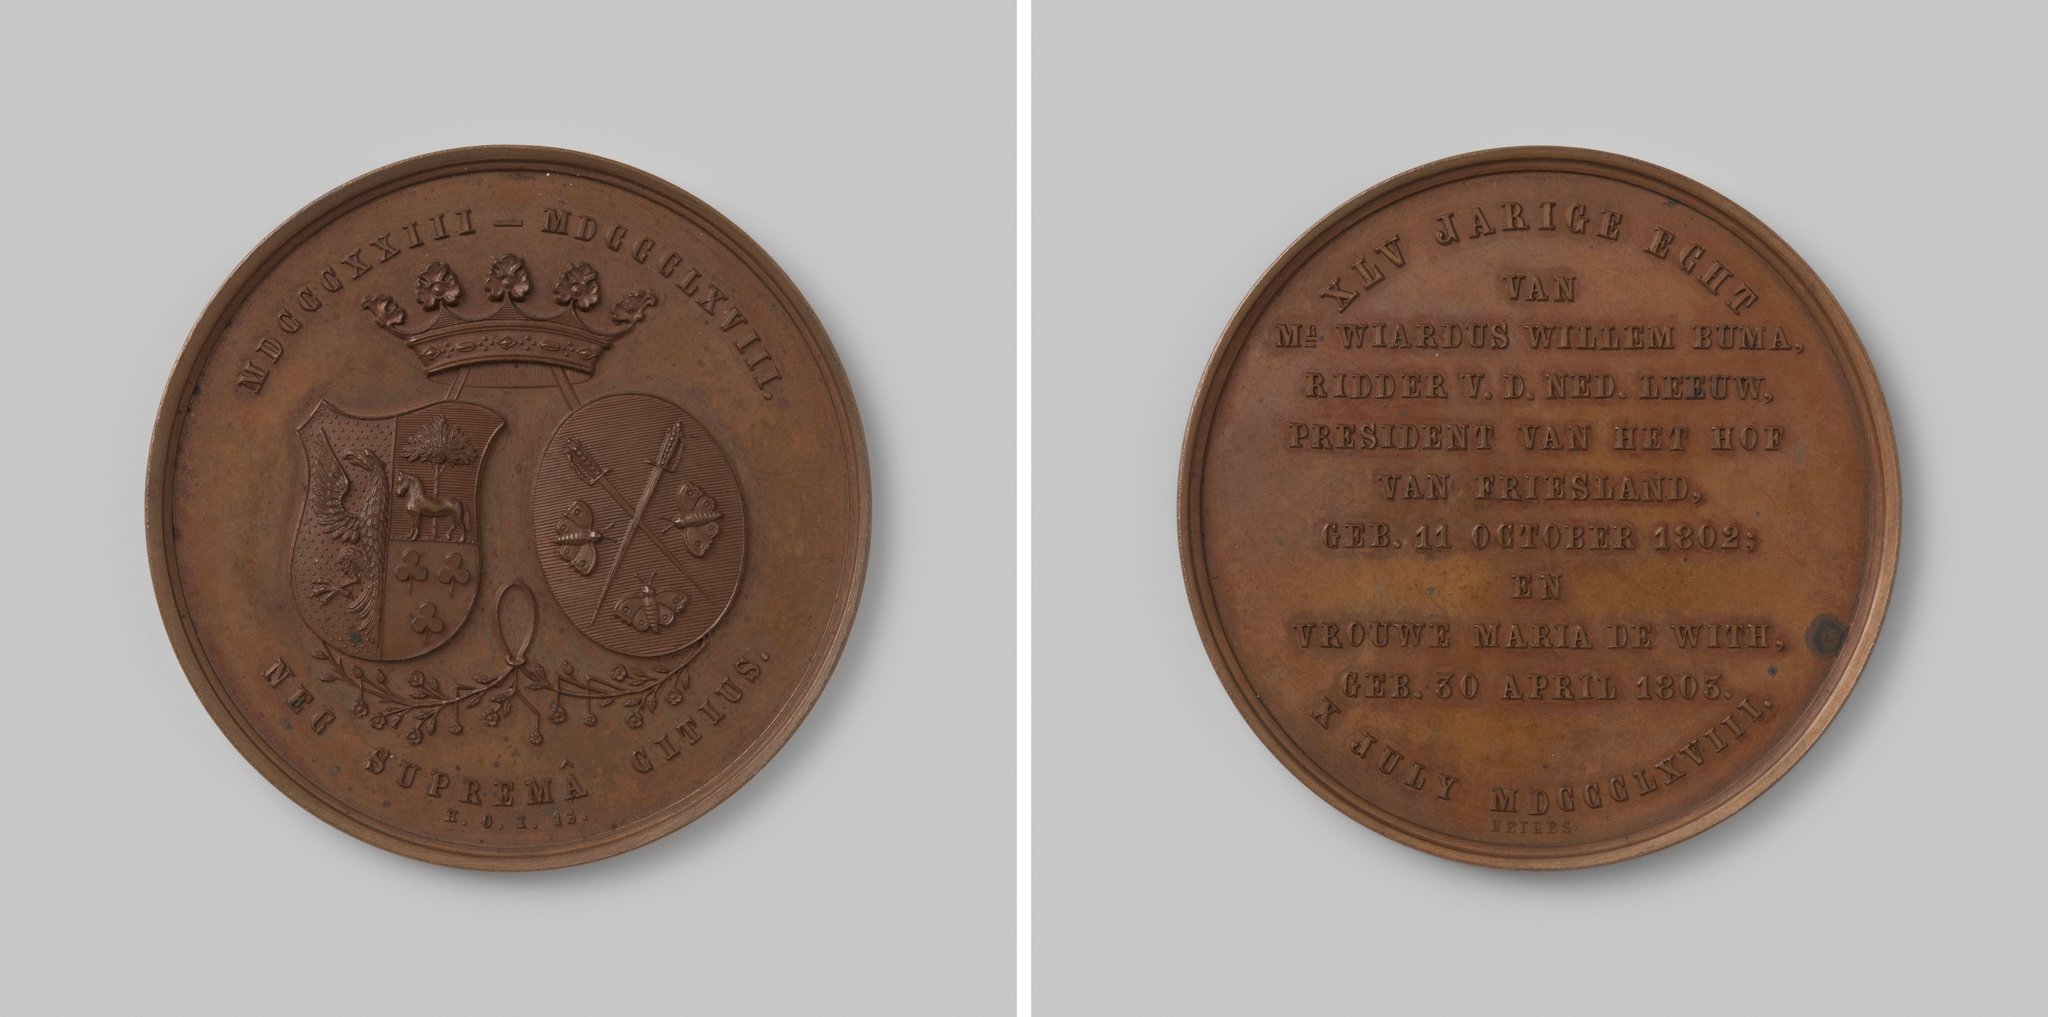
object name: marriage medal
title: Vijfenveertigjarig huwelijk van Wiardus Willem Buma, raadsheer aan het Hof van Friesland en Maria de With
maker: tjeerd keikes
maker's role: medailleur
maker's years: 1804-1886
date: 1868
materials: bronze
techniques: striking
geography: leeuwarden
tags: maria de with, wiardus willem buma, hof van friesland, friesland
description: Bronzen penning. Voorzijde: twee wapenschilden aan lint onder kroon hangend boven takken van vergeet-mij-nietjes binnen omschrift. Keerzijde: opschrift binnen omschrift